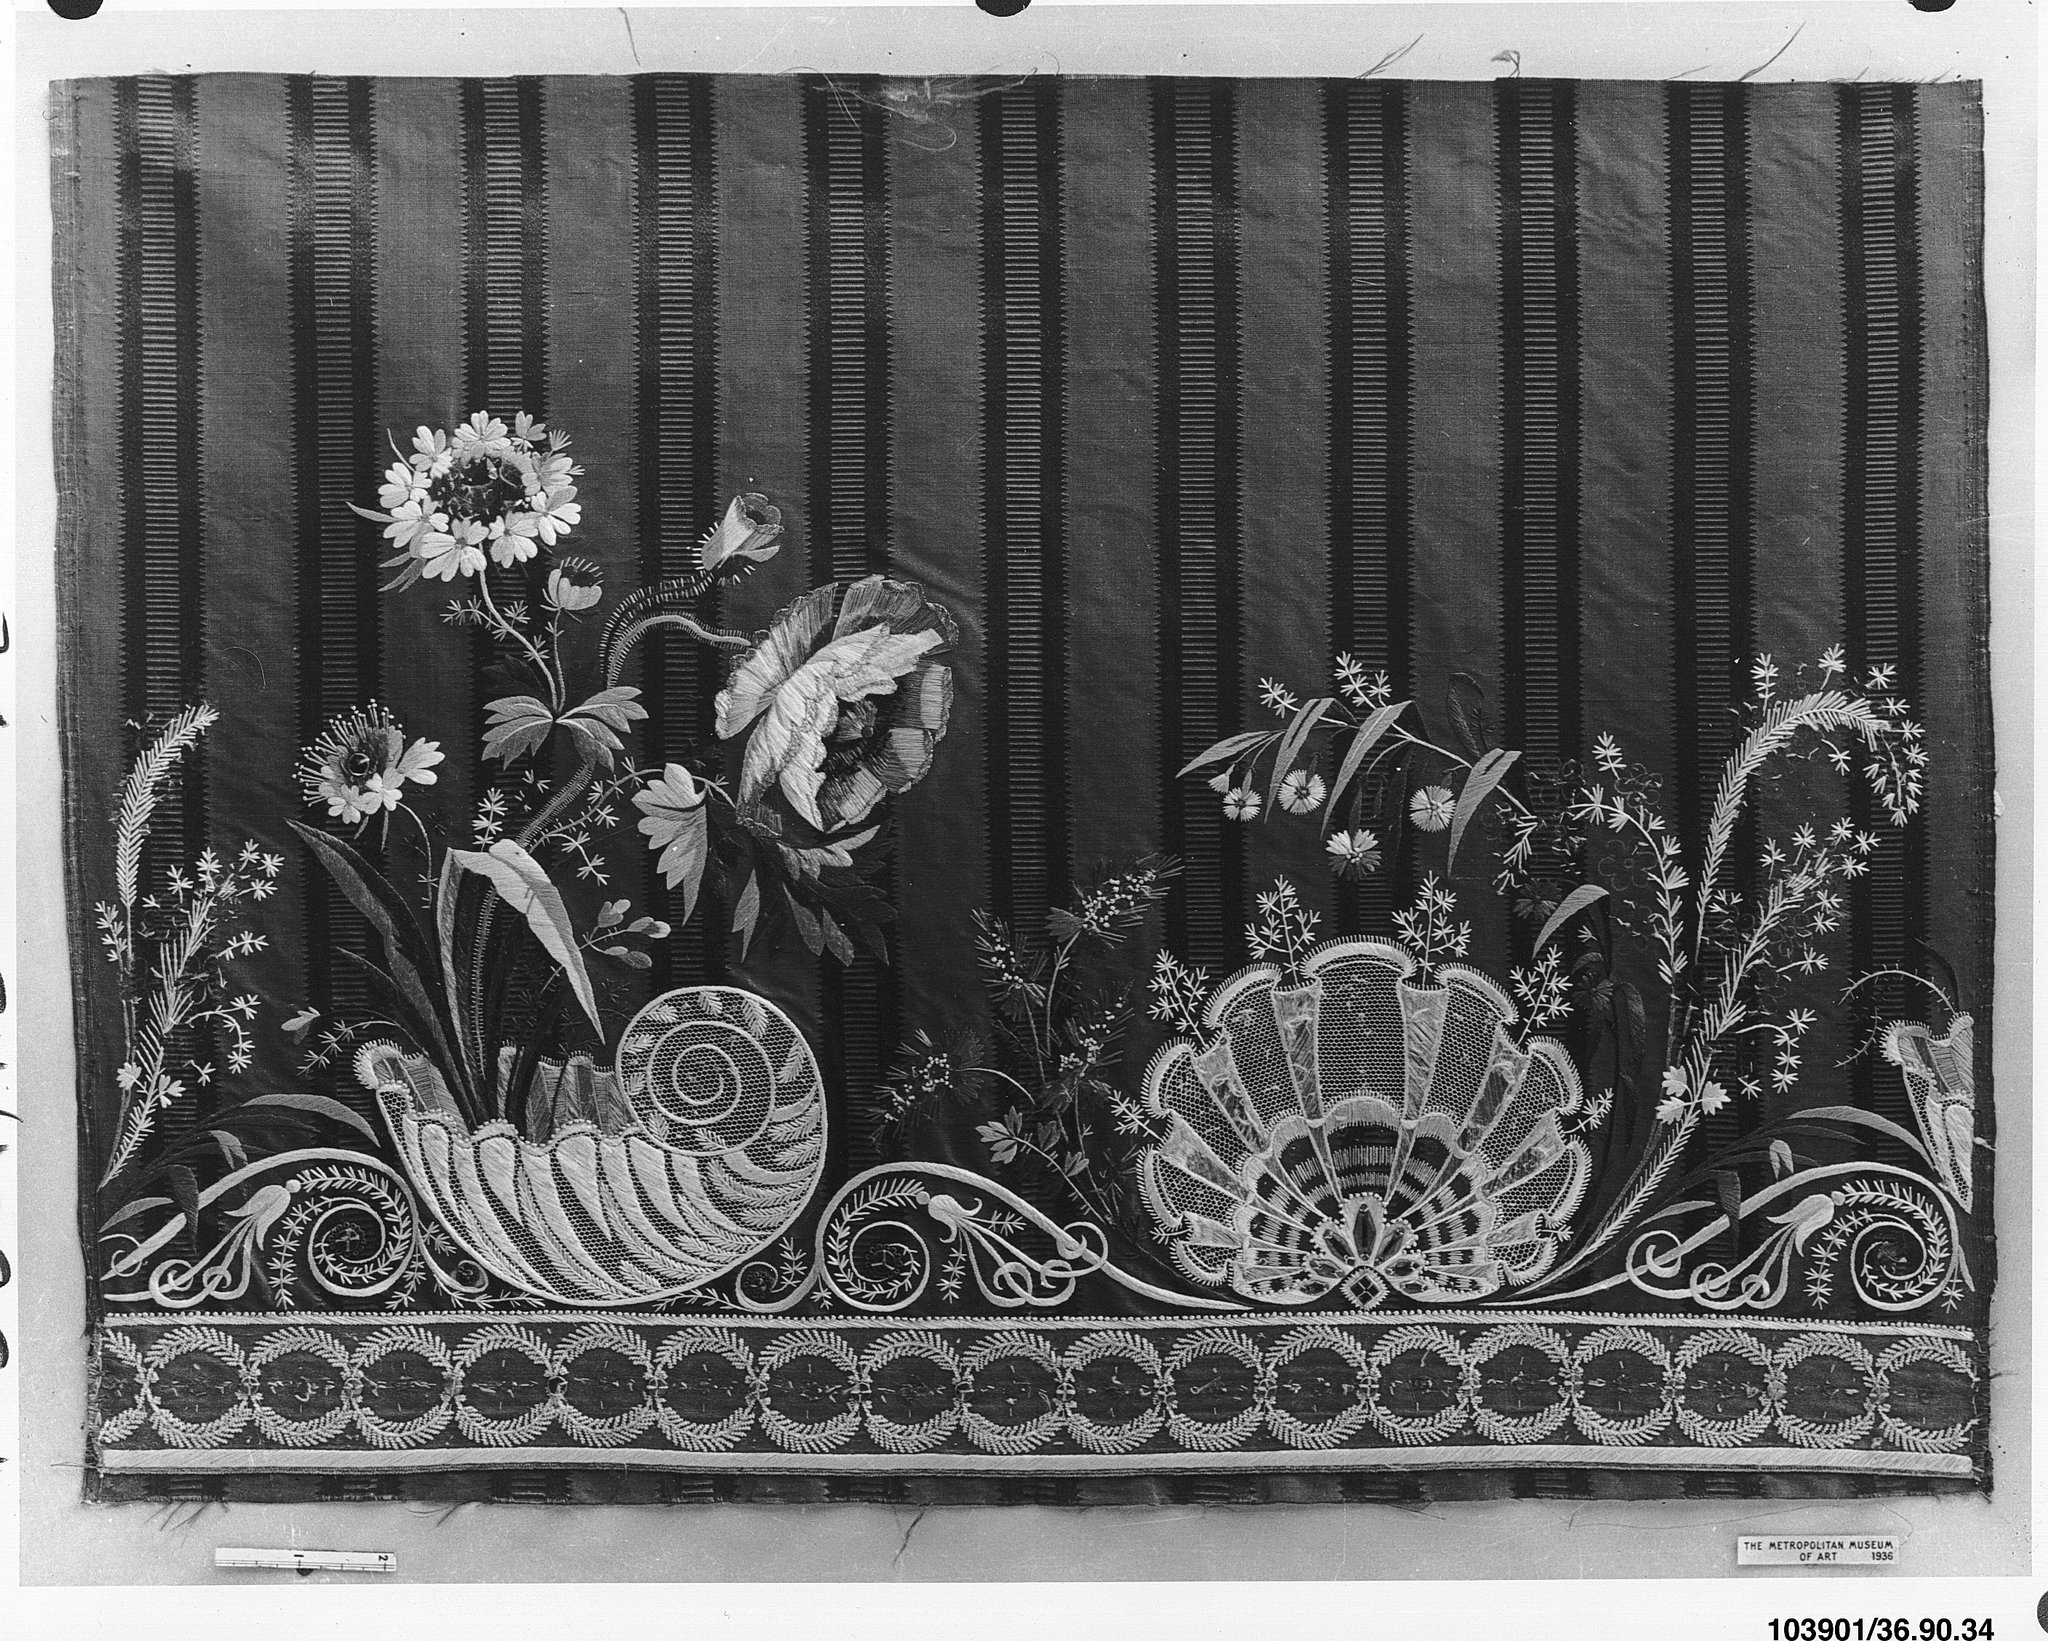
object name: border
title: Dress border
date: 1801-1833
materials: silk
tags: flowers